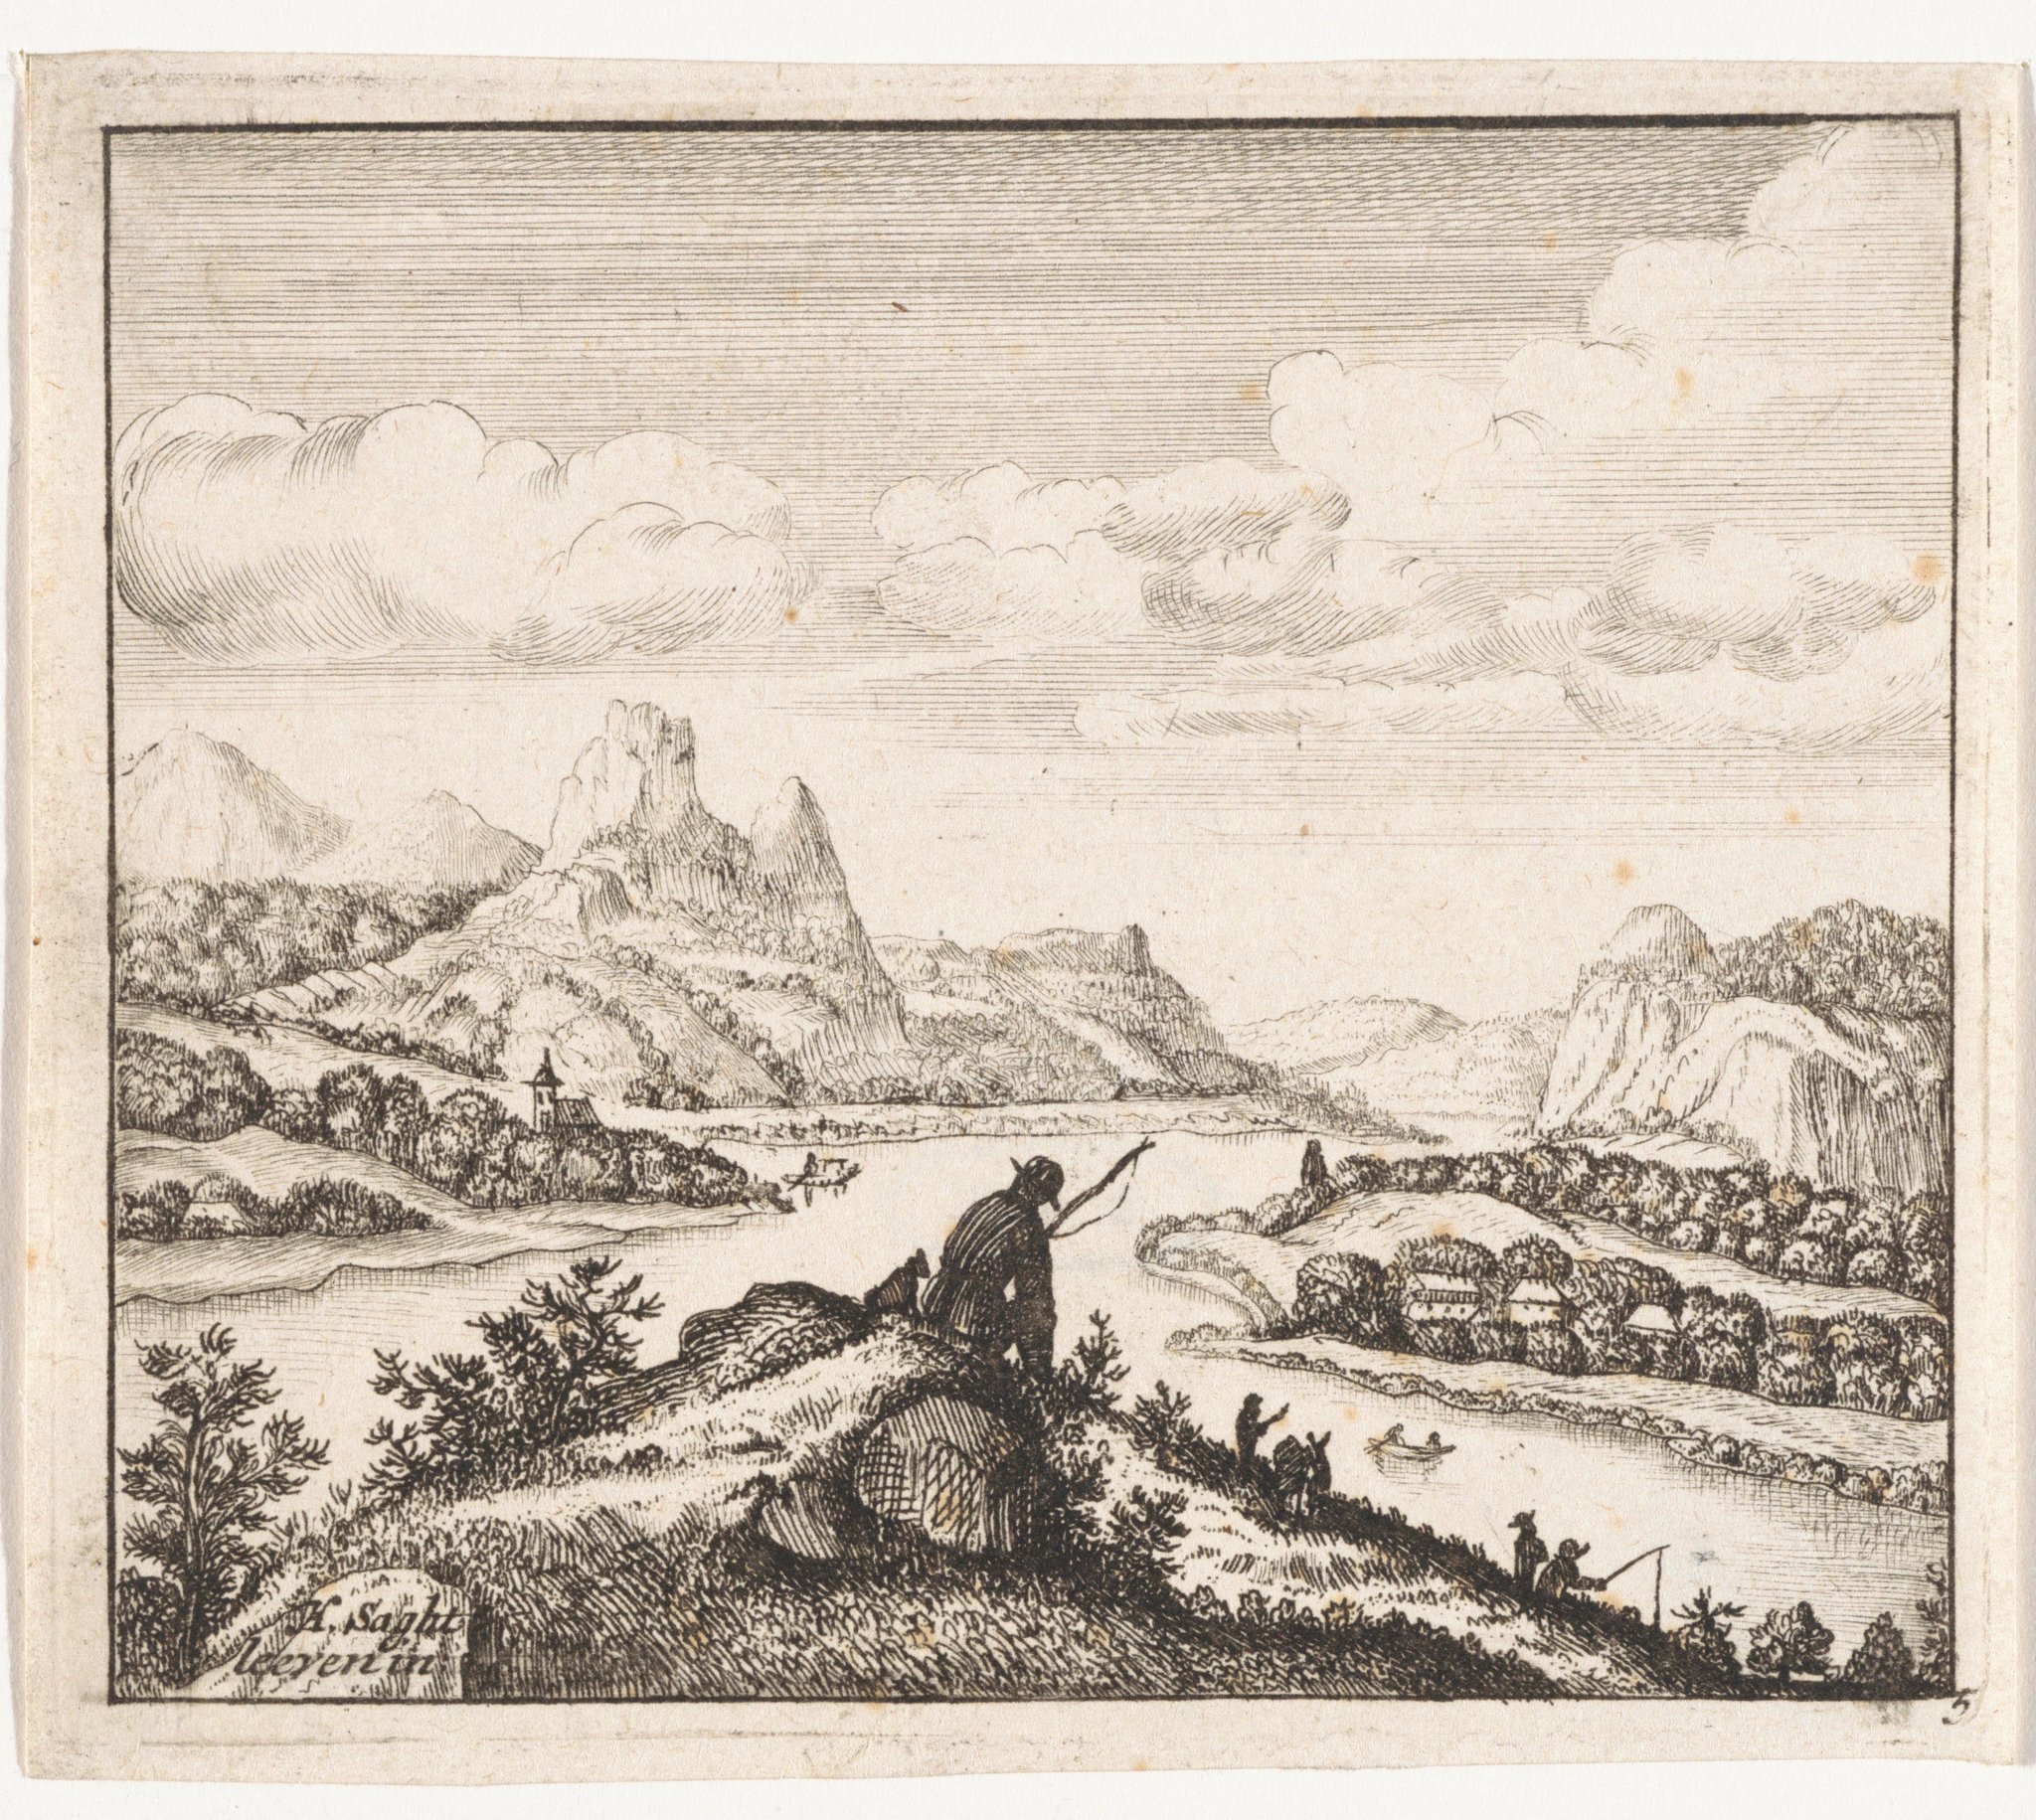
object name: print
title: Rivierlandschap met vissers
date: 1668-1707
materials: paper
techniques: etching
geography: northern netherlands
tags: river, fisherman, mountains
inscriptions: collector's mark: Lugt 2228, collector's mark: Lugt 2396, collector's mark: Lugt 2357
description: Vooraan zitten enkele vissers op een heuvel. In het dal stroomt een rivier. Links in de verte liggen enkele hoge bergen.